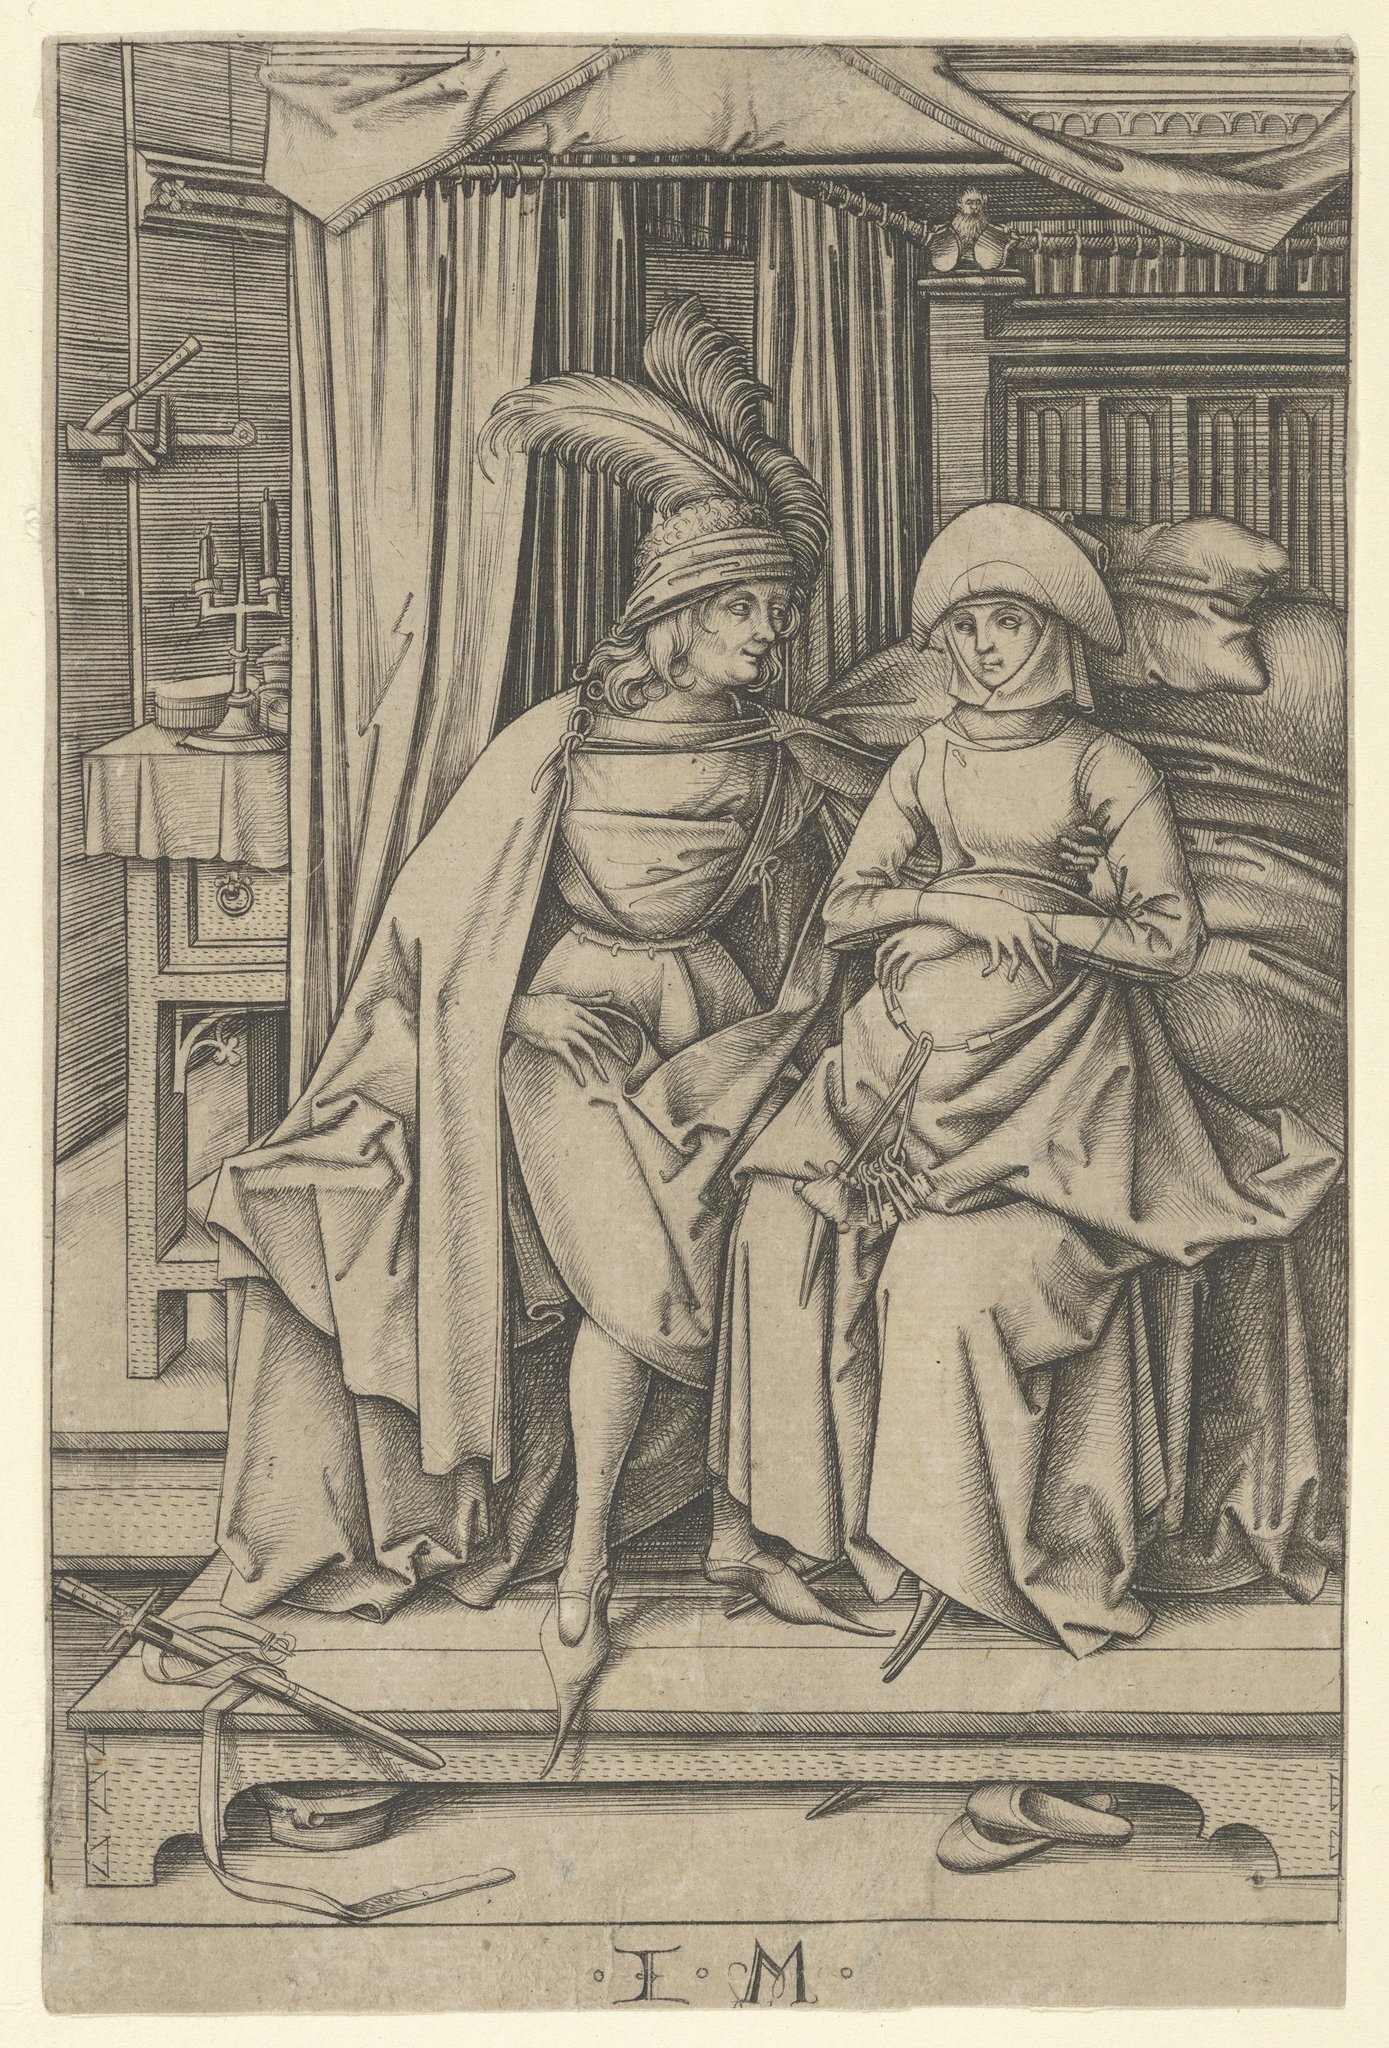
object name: print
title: Couple Seated on a Bed, from Scenes of Daily Life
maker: israhel van meckenem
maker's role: artist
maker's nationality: german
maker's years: 1435-1503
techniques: engraving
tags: couples,men,women